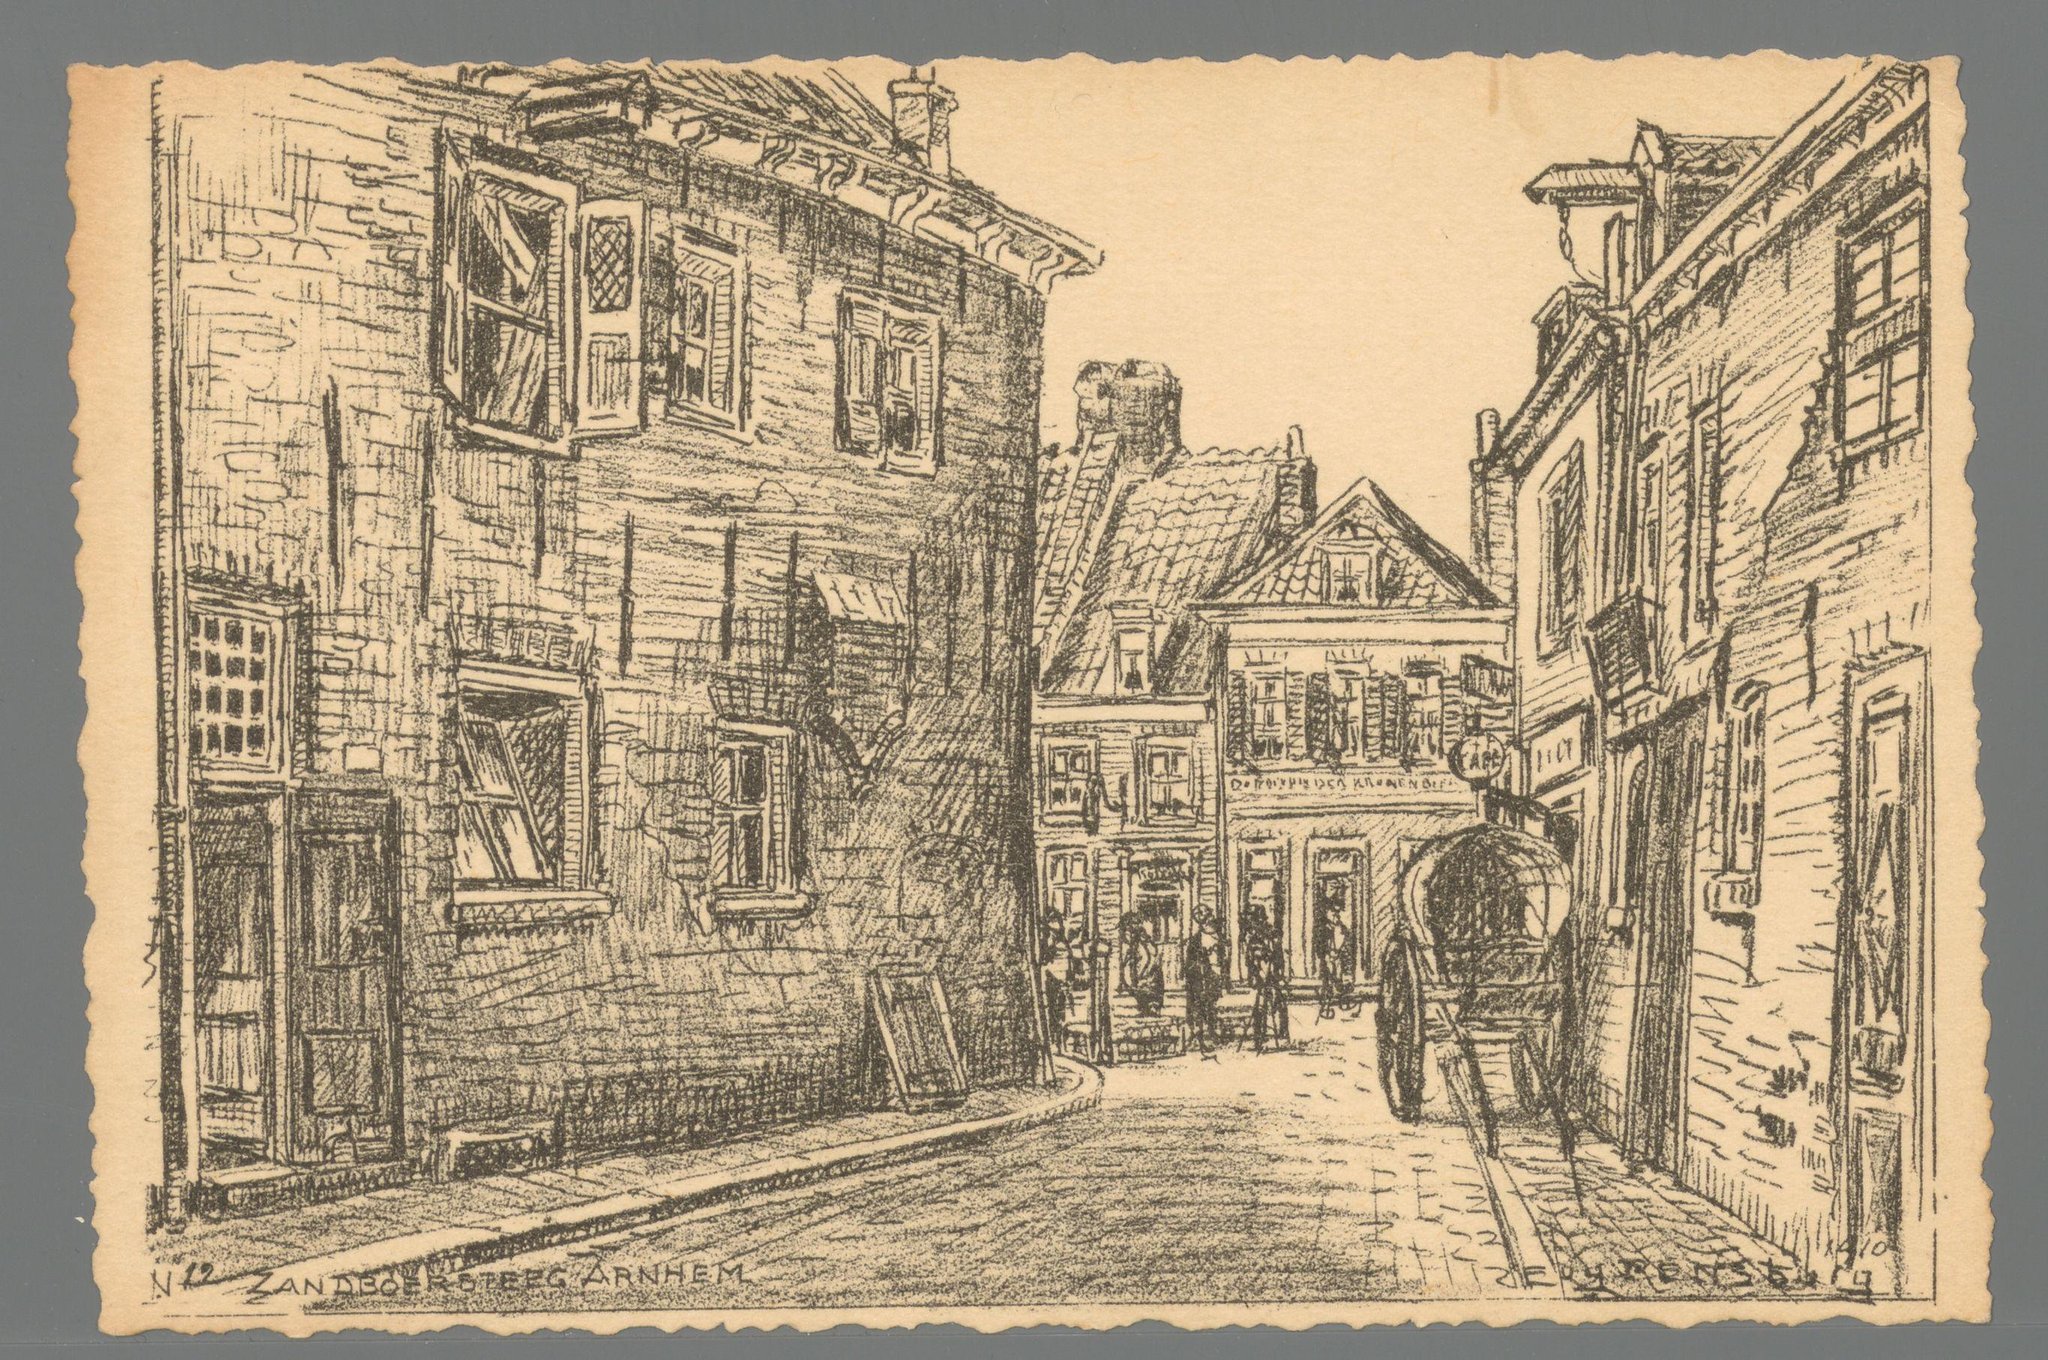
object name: print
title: Zandboersteeg. Arnhem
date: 1942-1947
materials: cardboard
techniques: lithograph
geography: arnhem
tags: village lane, alley, arnhem